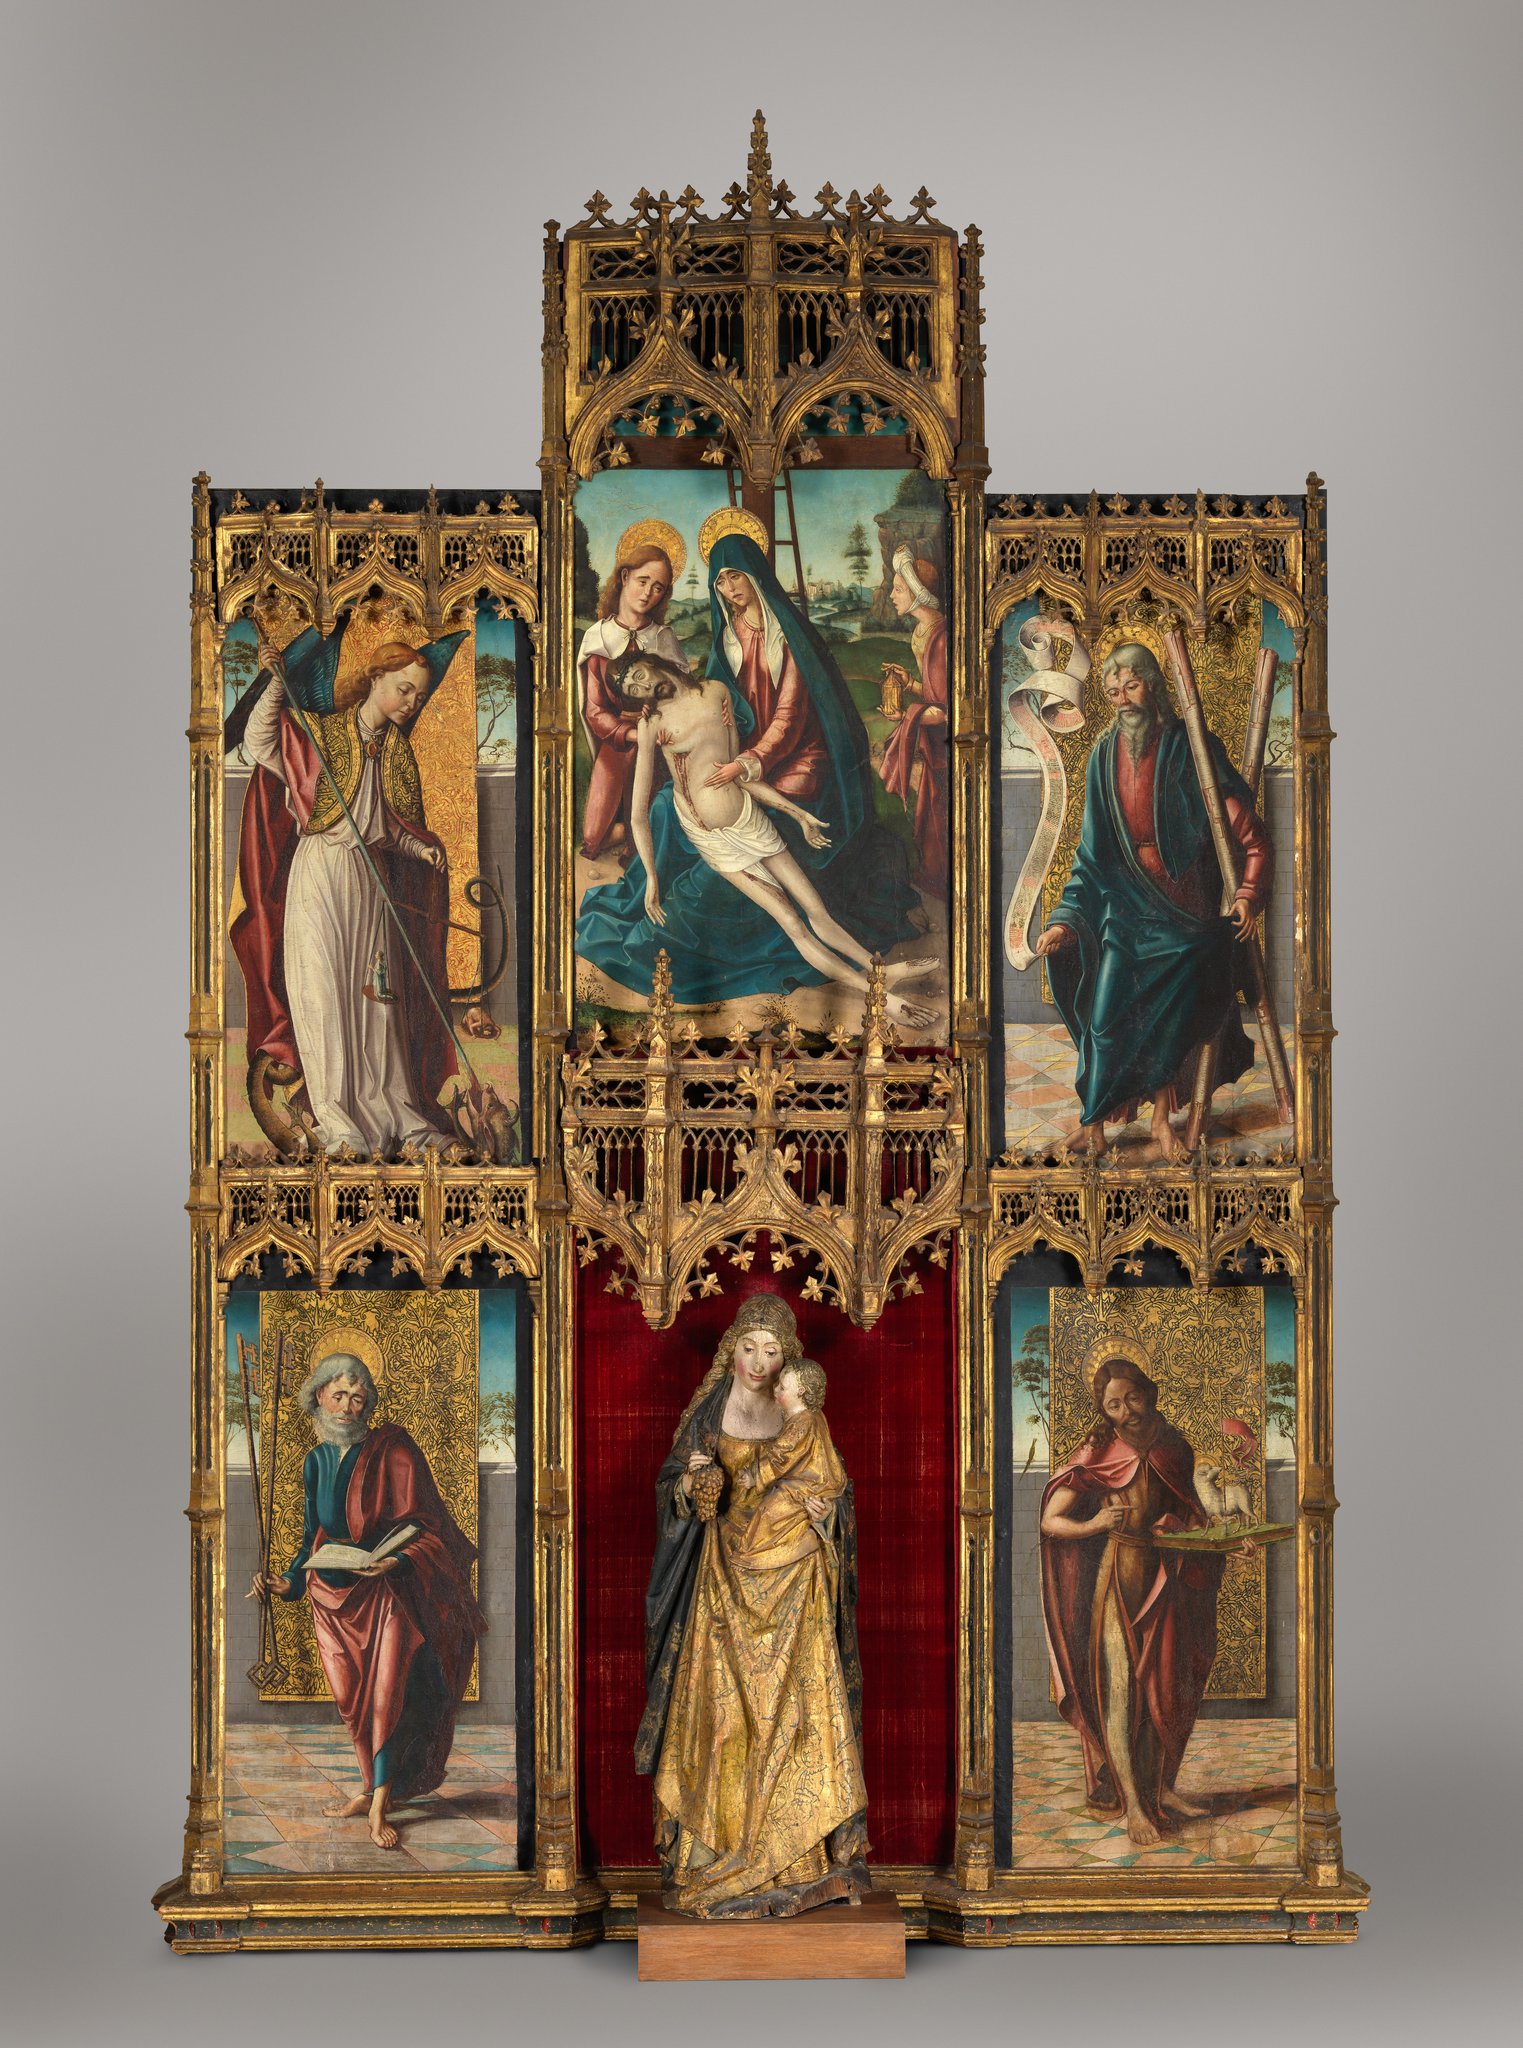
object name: painting, retable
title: Virgin and Child with the Pietà and Saints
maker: spanish (castilian) painter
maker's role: artist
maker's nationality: spanish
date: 1470-1499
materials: gold, paint, wood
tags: dragons,angels,christ,madonna and child,mary magdalene,saint john the baptist,saint john the evangelist,saint peter,virgin mary,saints